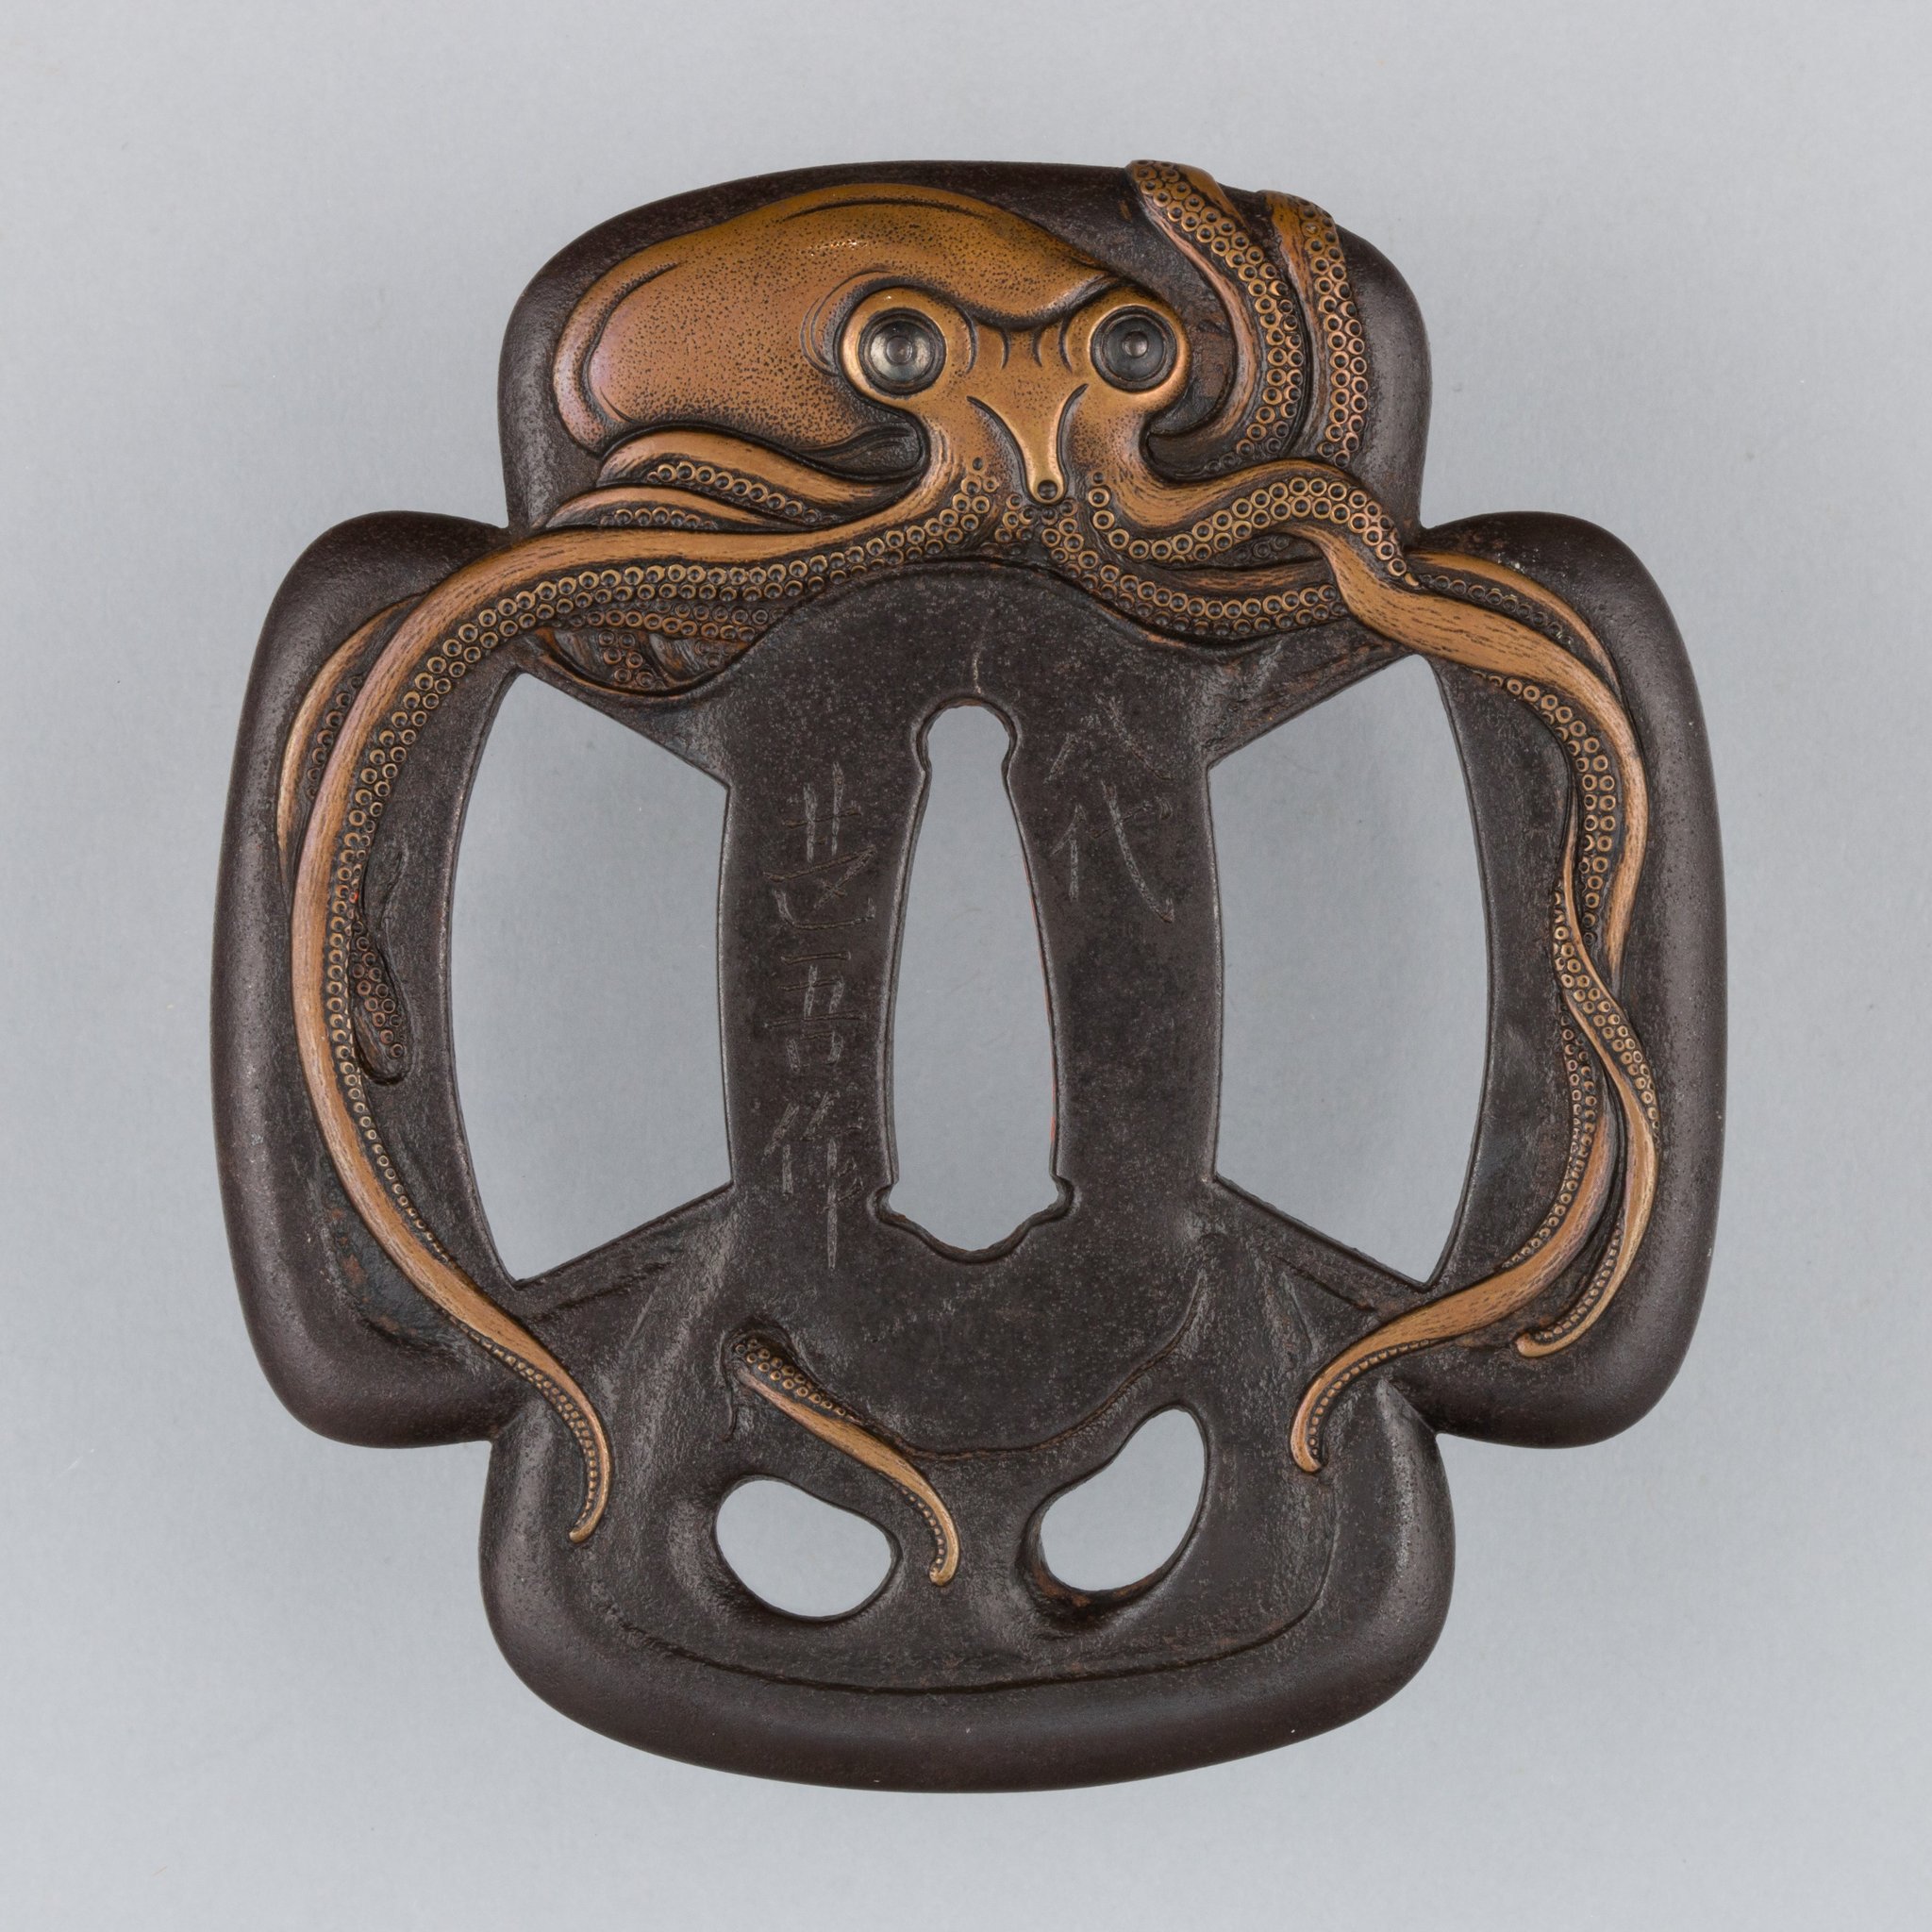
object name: sword guard tsuba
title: Sword Guard (Tsuba)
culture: japanese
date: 1767-1800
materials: copper, iron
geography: japan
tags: octopus